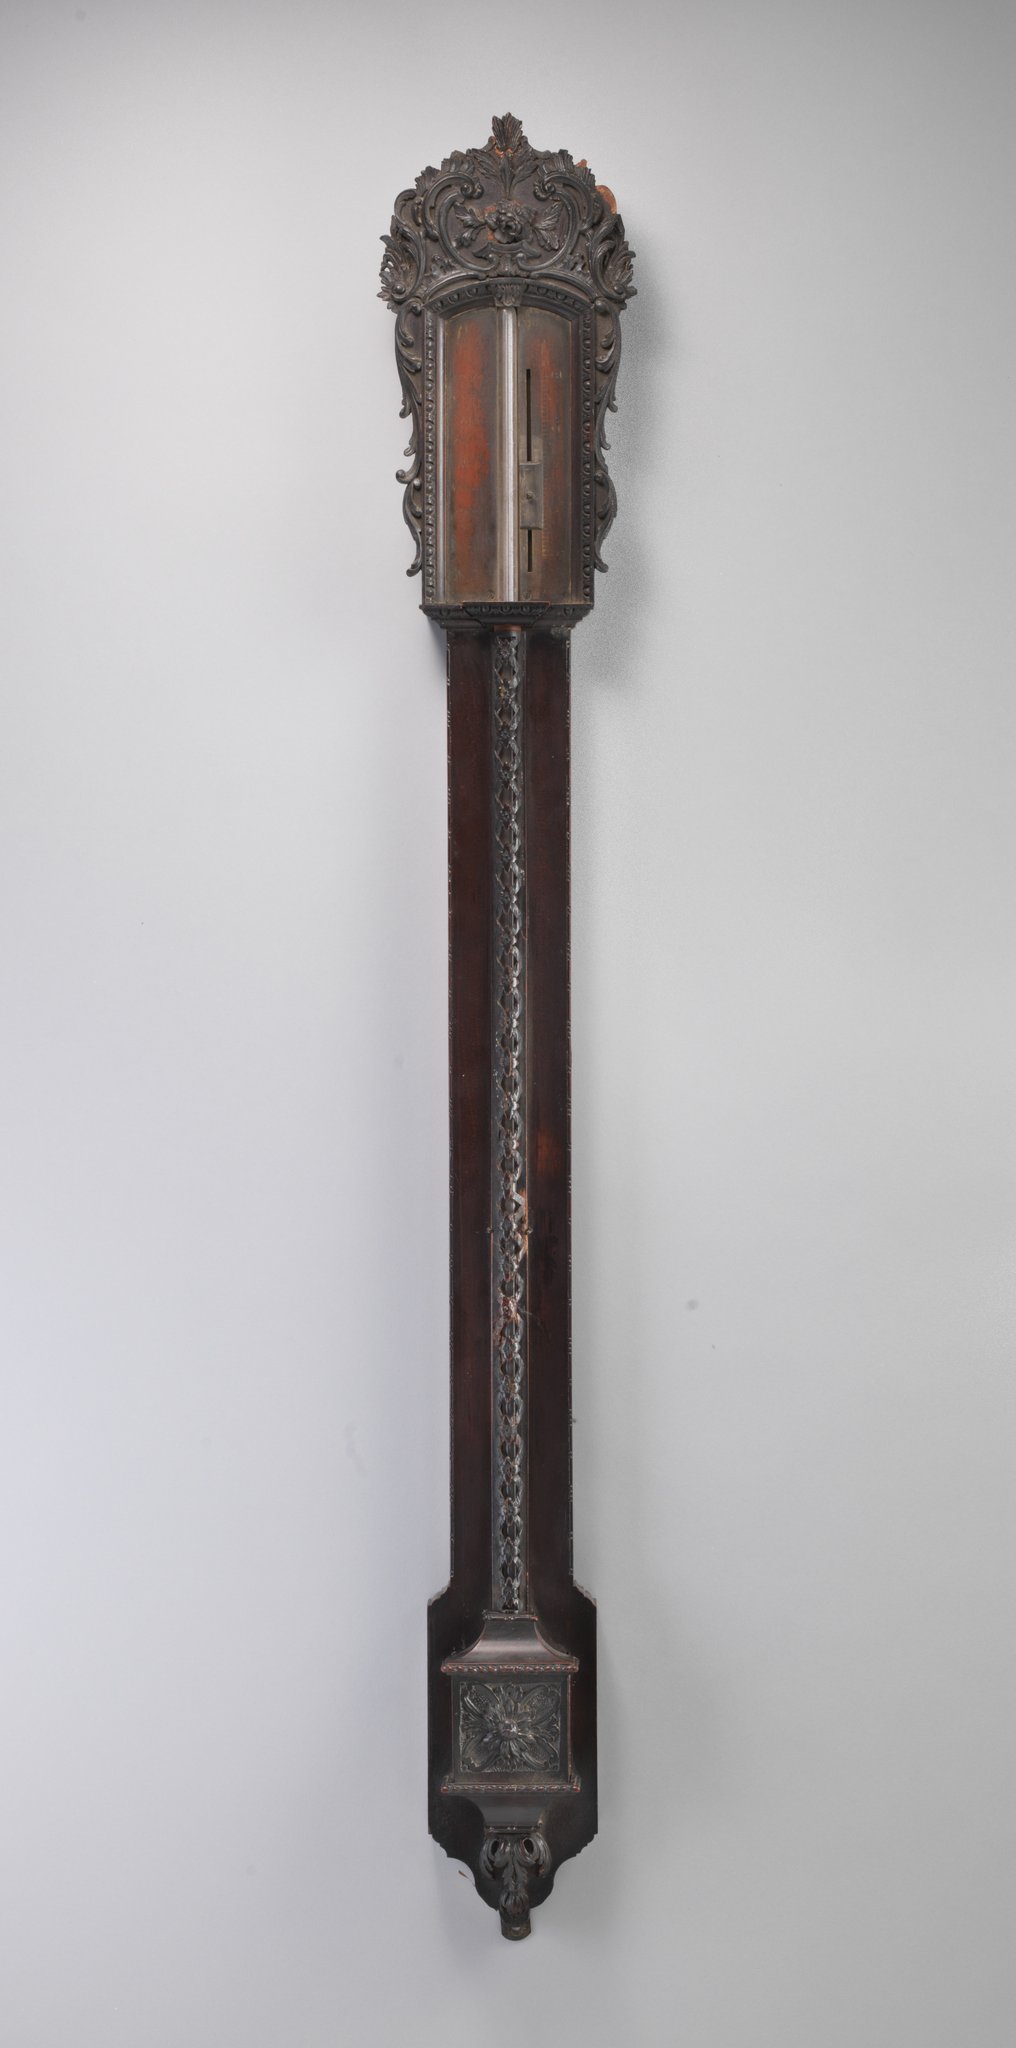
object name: torricellian barometer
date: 1750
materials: wood, mercury